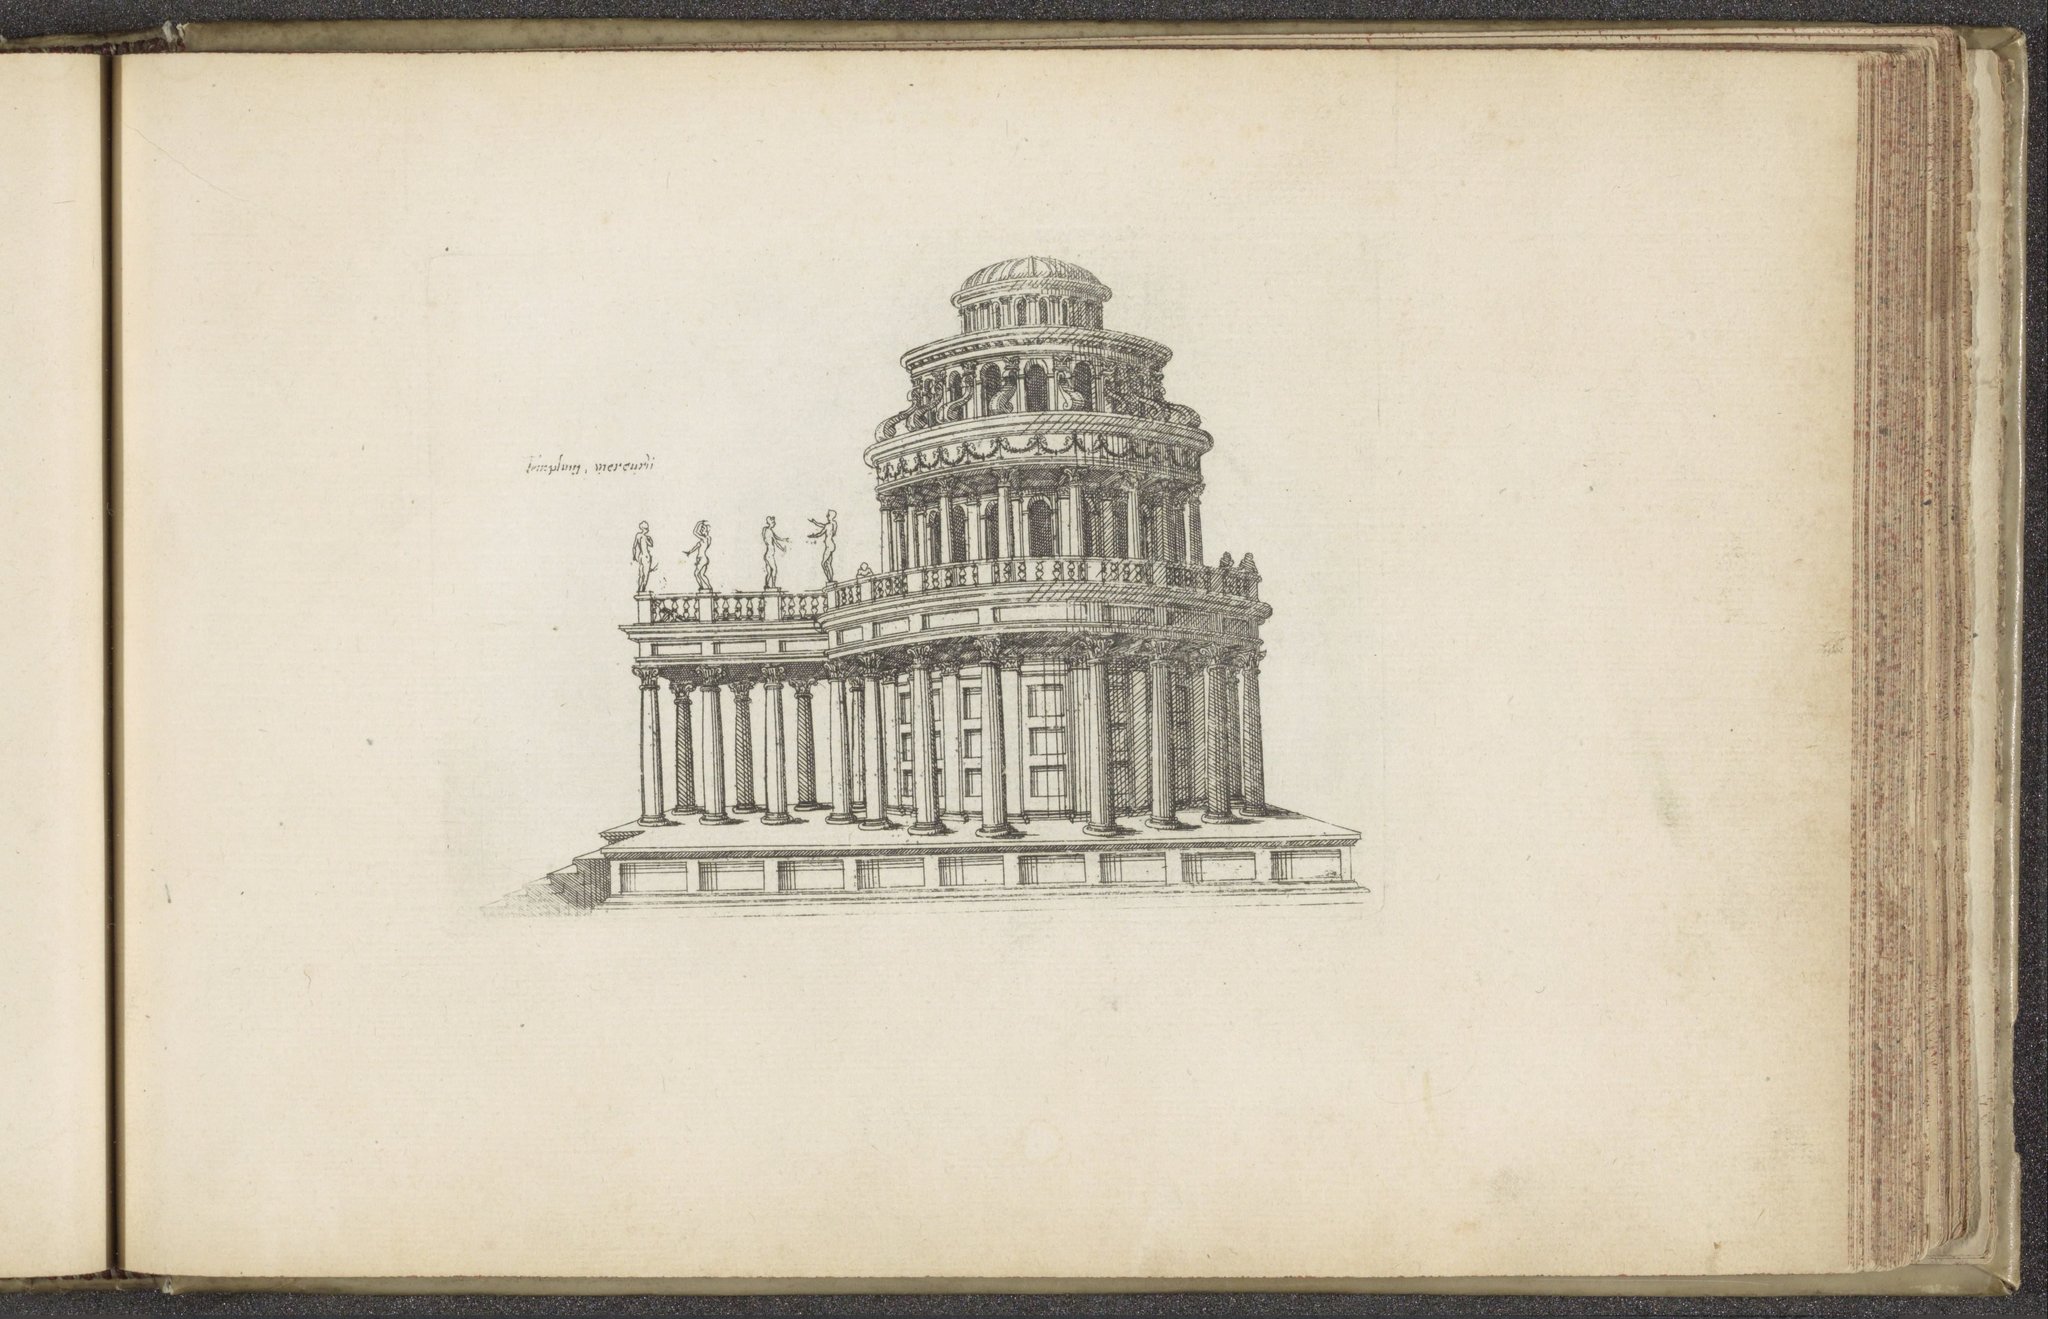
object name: album leaf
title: Iacobus Androuetius Du Cerceau Lectoribus S Quoniam apud veteres alio structurae genere templa (...)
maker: jacques androuet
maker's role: draughtsman, print maker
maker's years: 1515-1584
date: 1550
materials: paper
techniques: etching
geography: orléans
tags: exterior ~ representation of a building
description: Tempel van Mercurius. Deze prent maakt deel uit van een album.